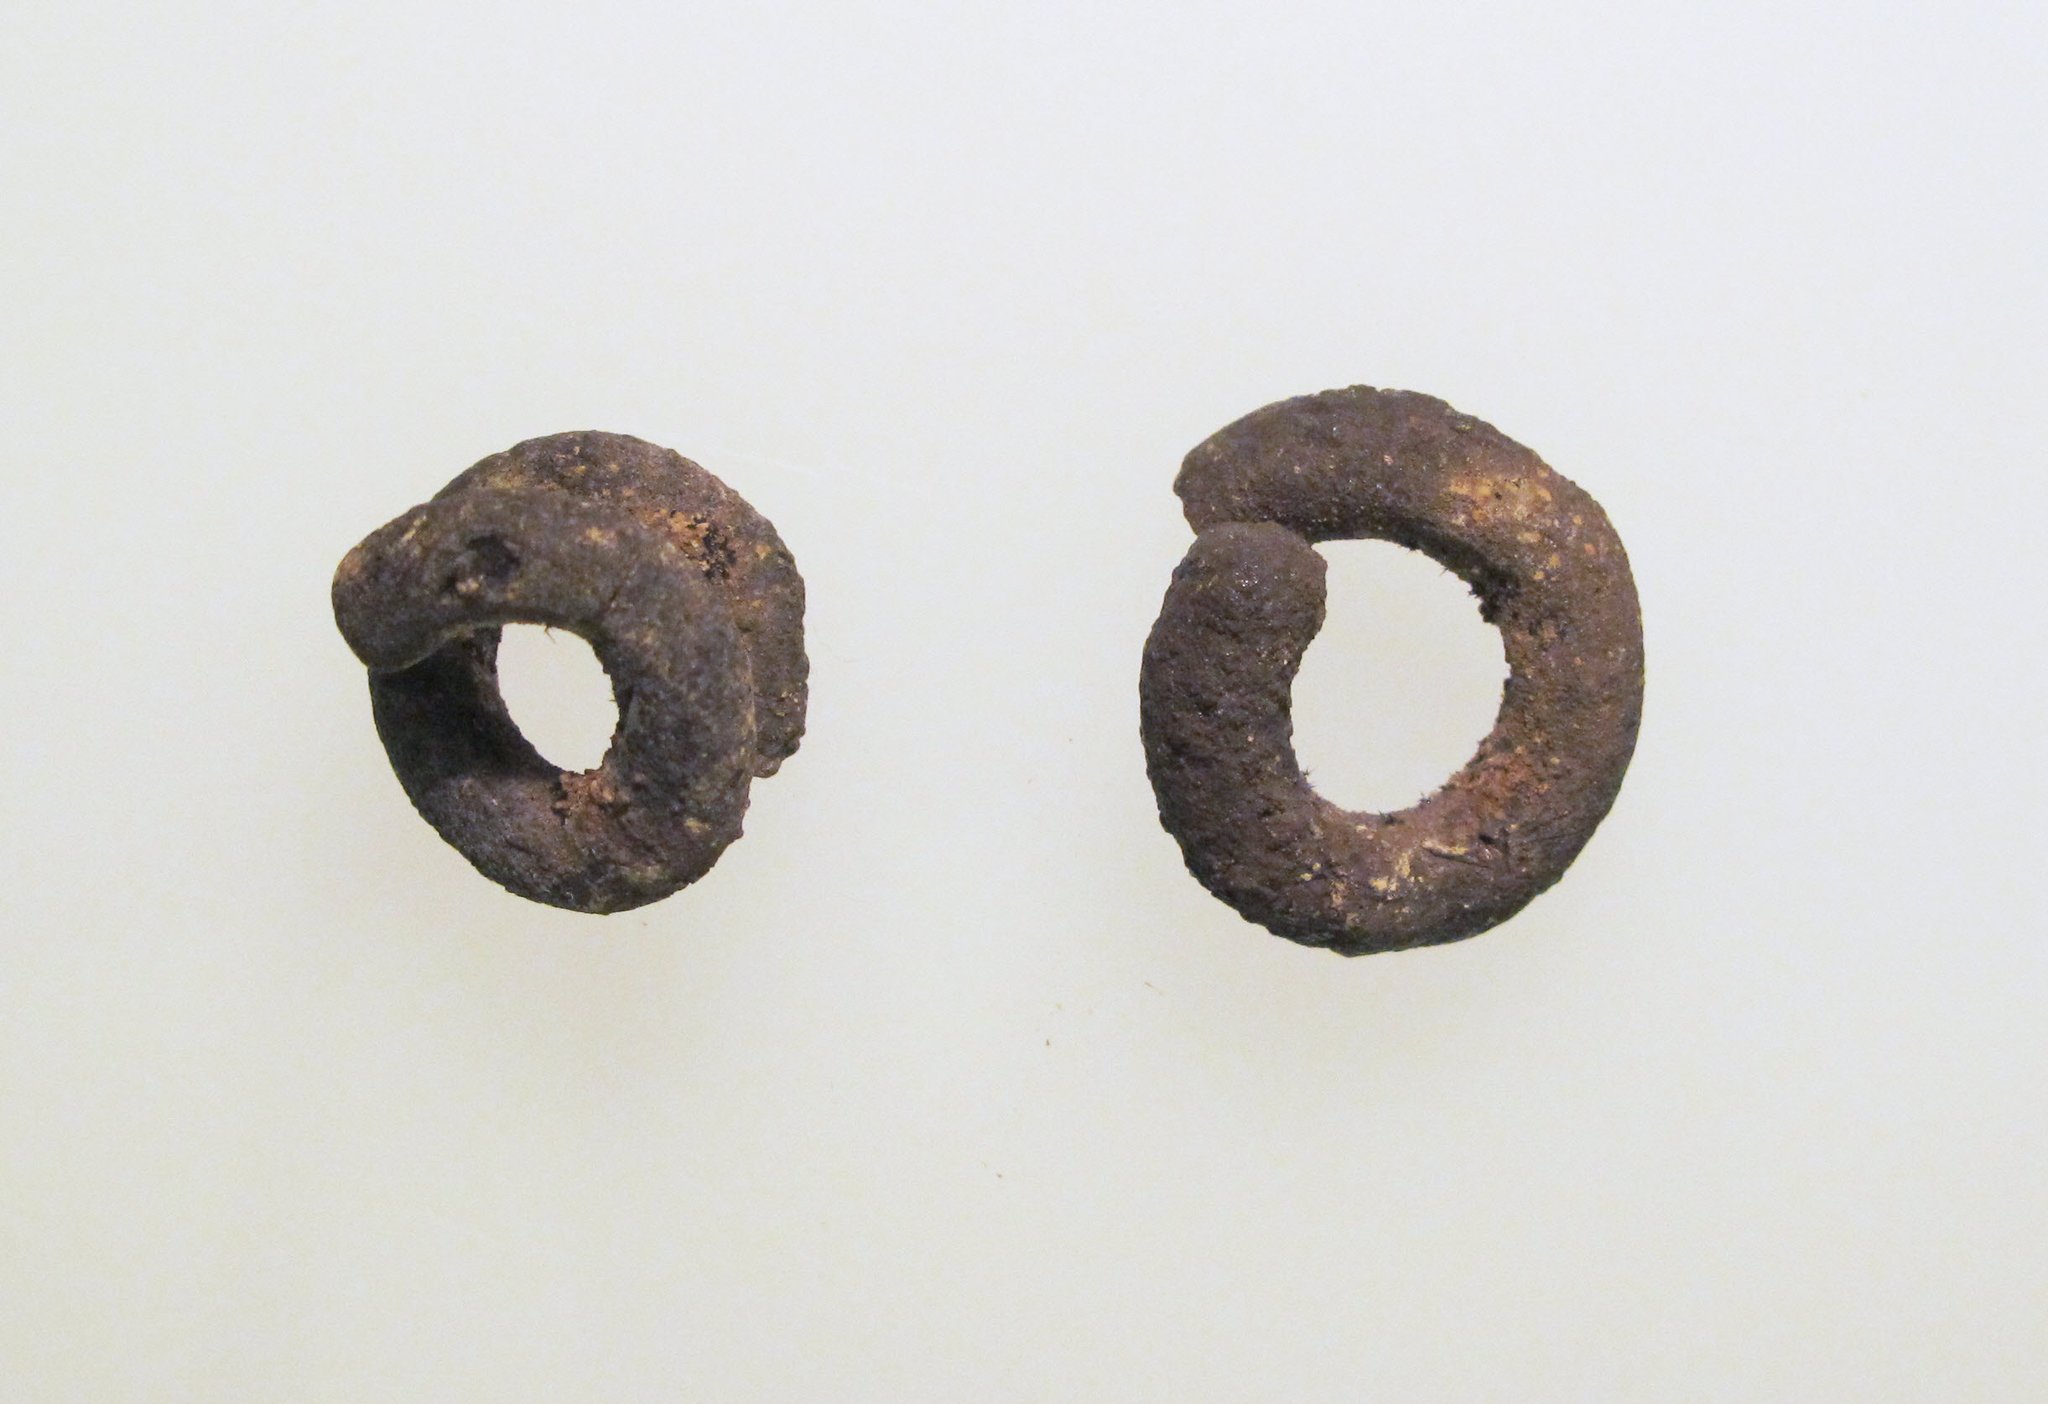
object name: earring or spiral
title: Silver earring or spiral, orginally connected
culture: cypriot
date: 500-401 BCE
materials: silver